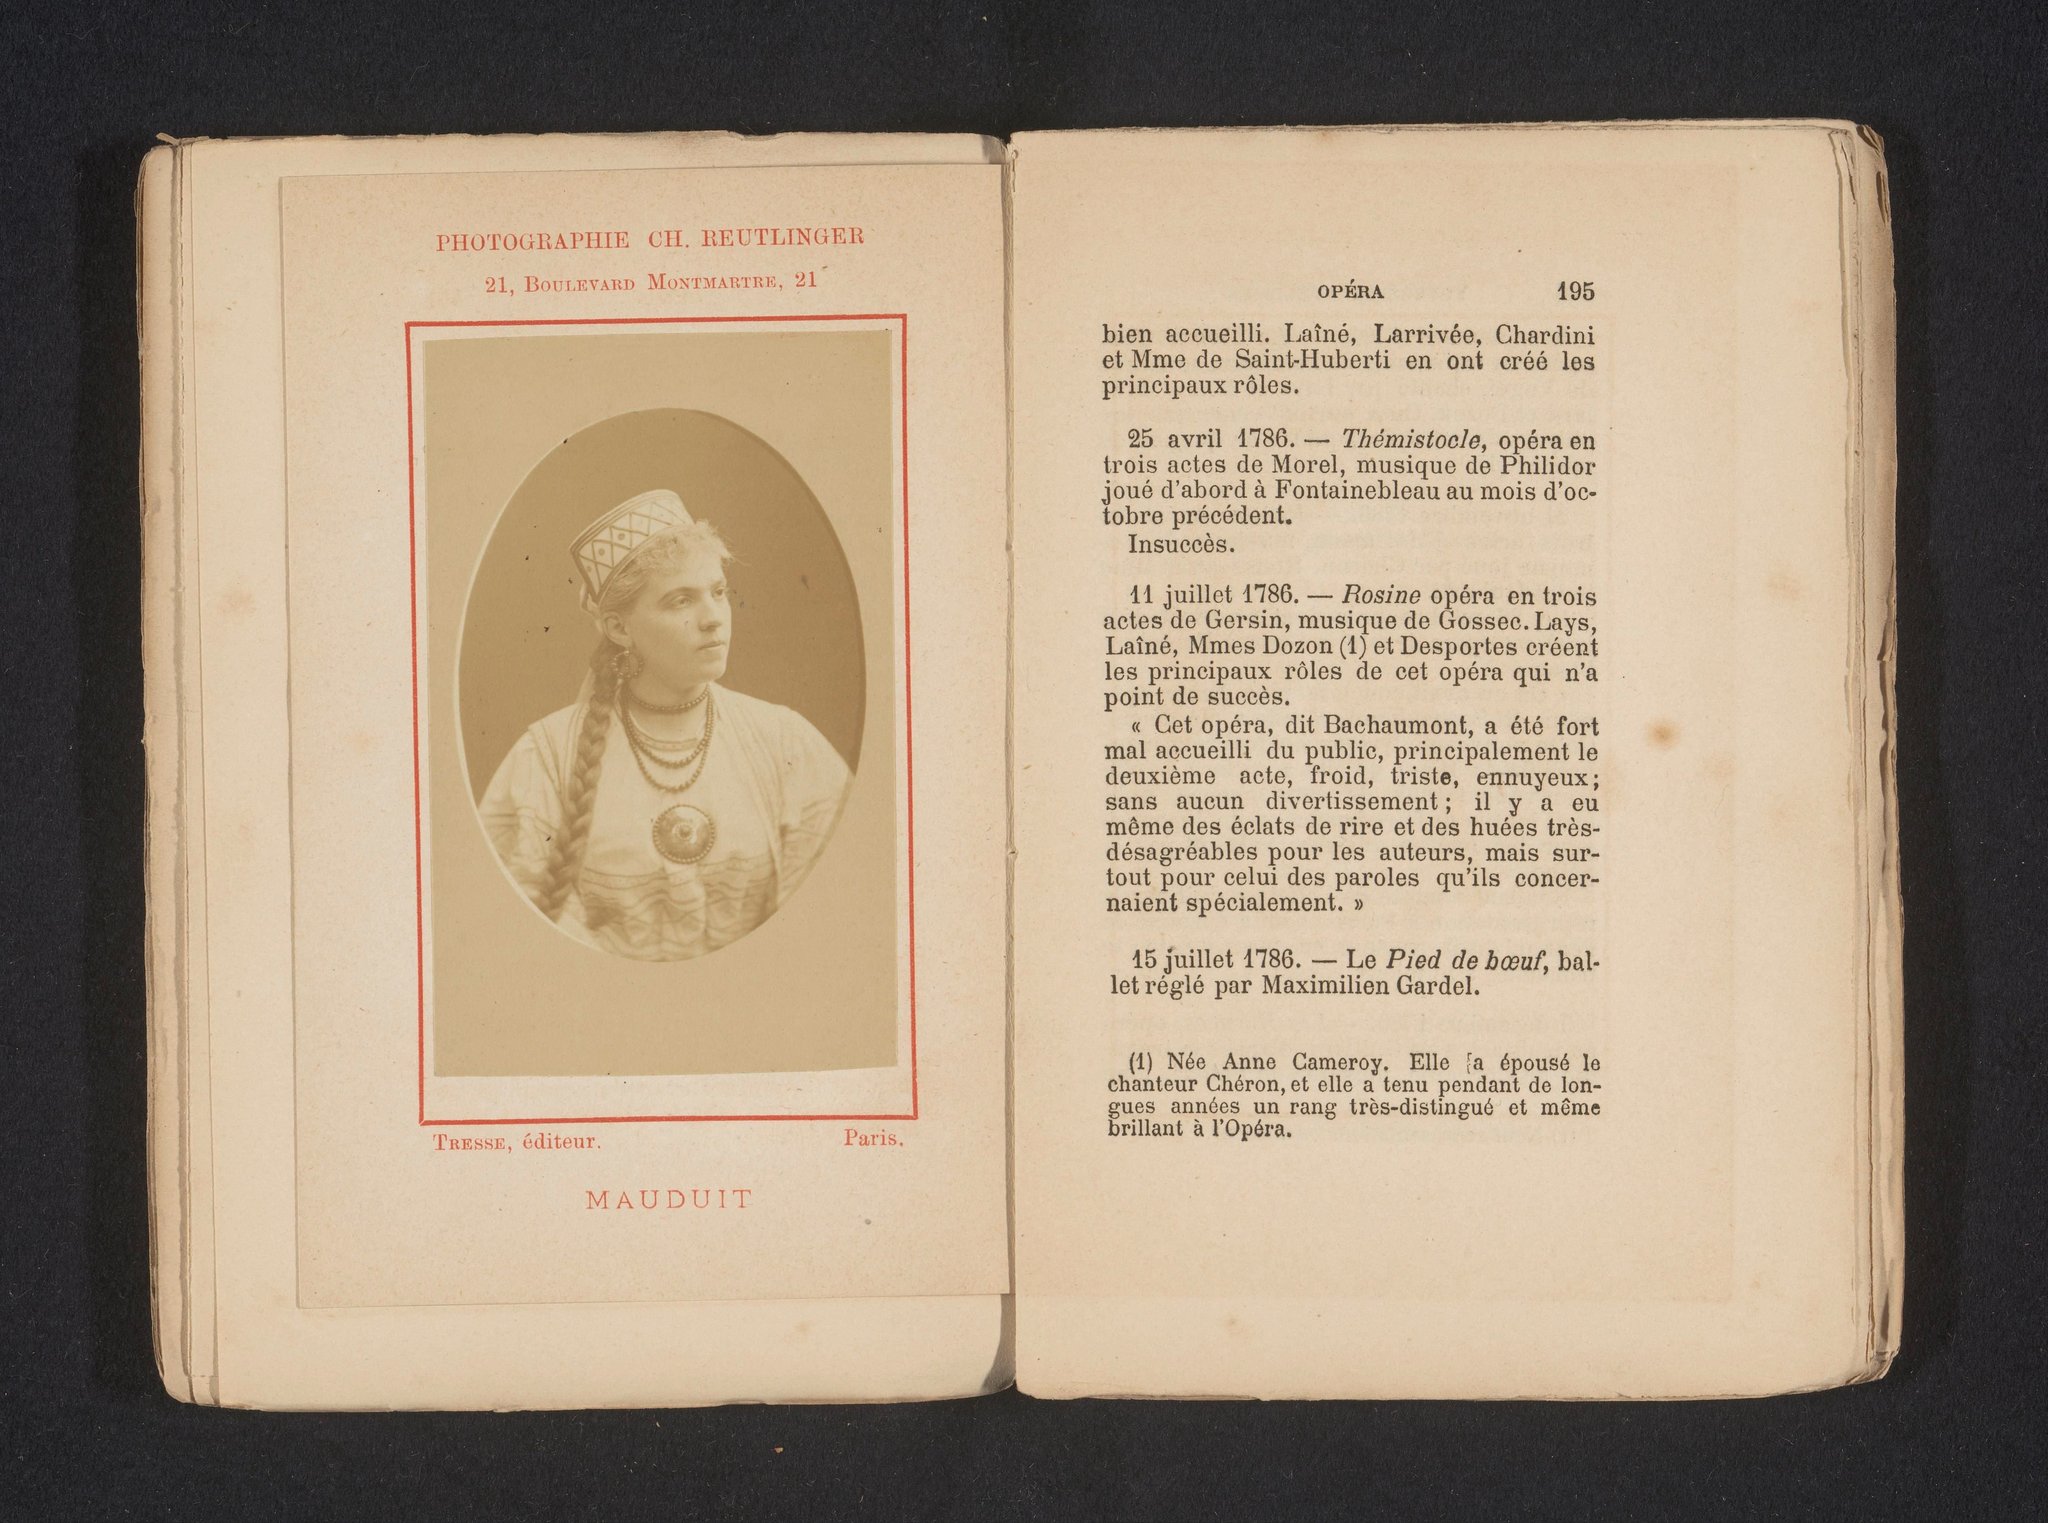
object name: page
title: Mauduit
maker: charles reutlinger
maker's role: publisher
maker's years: 1816-1880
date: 1869-1874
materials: photographic support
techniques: albumen print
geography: paris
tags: portrait of opera-singer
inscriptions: name: ‘Photographie Ch. Reutlinger 21, Boulevard Montmartre, 21’